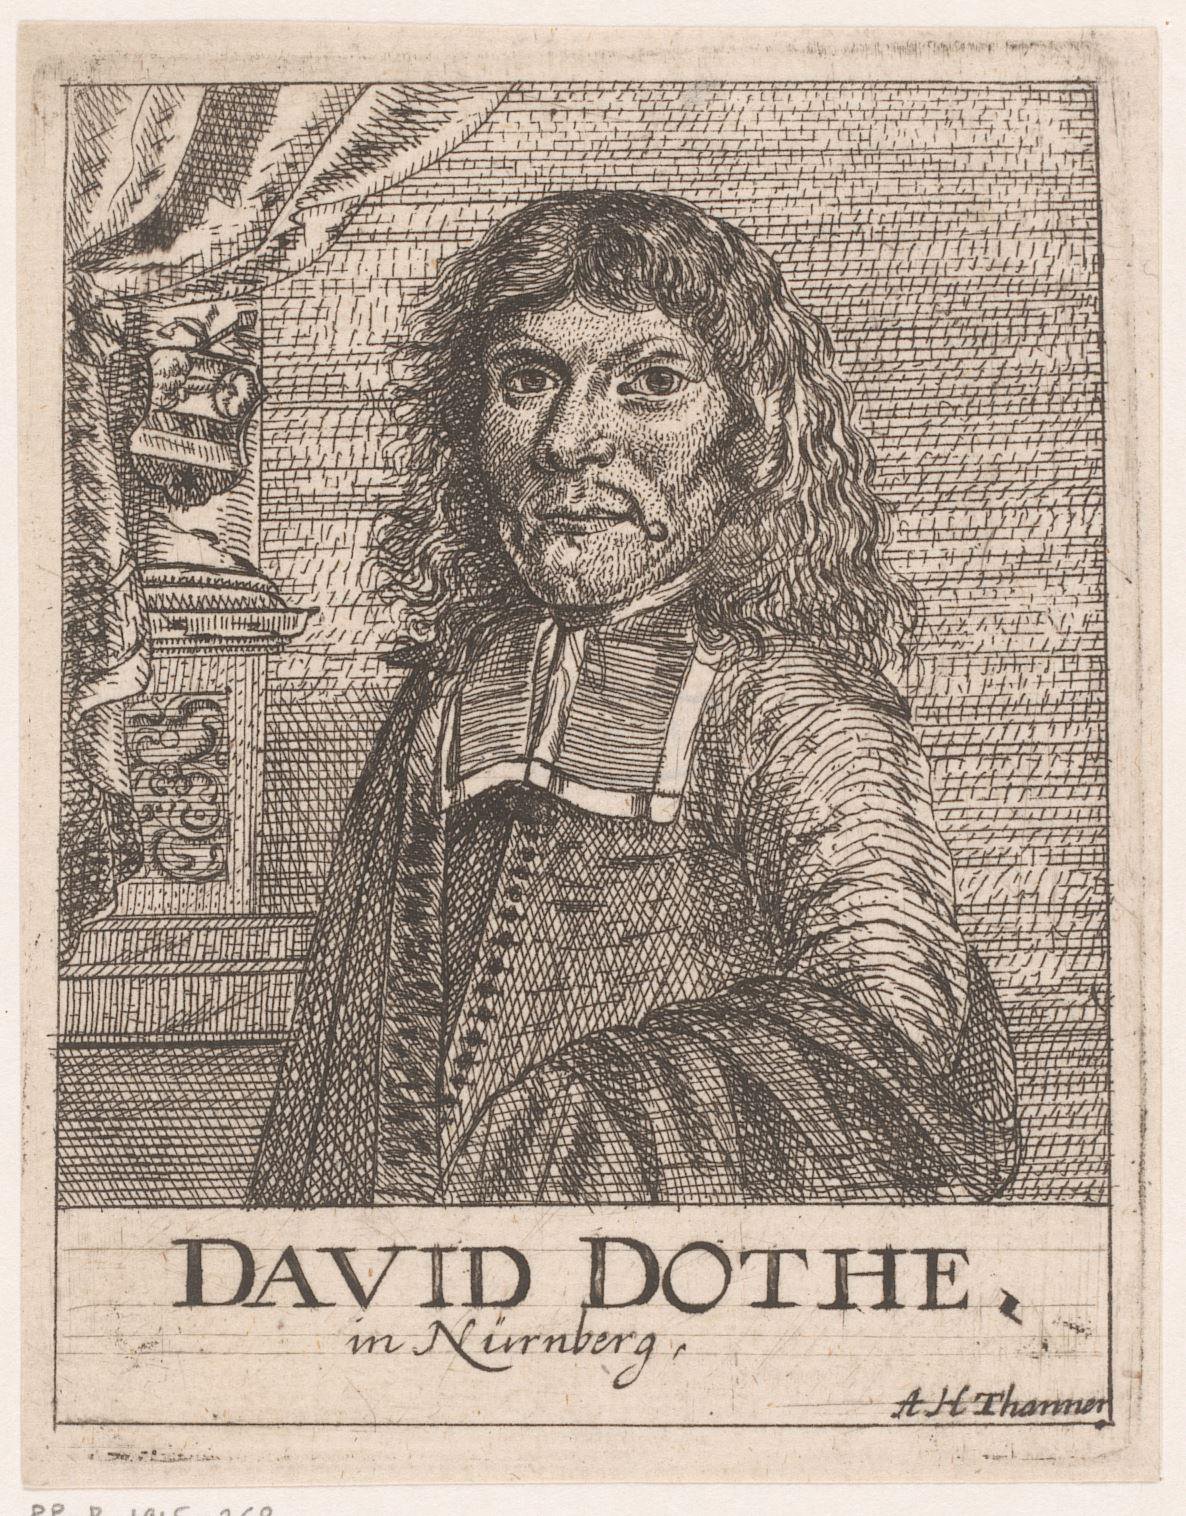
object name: print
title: Portret van David Dotte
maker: a.h. thanner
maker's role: print maker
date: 1650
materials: paper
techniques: etching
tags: goldsmith, historical persons, jeweller, goldsmith, silversmith, armorial bearing, heraldry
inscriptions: collector's mark: Lugt 2228